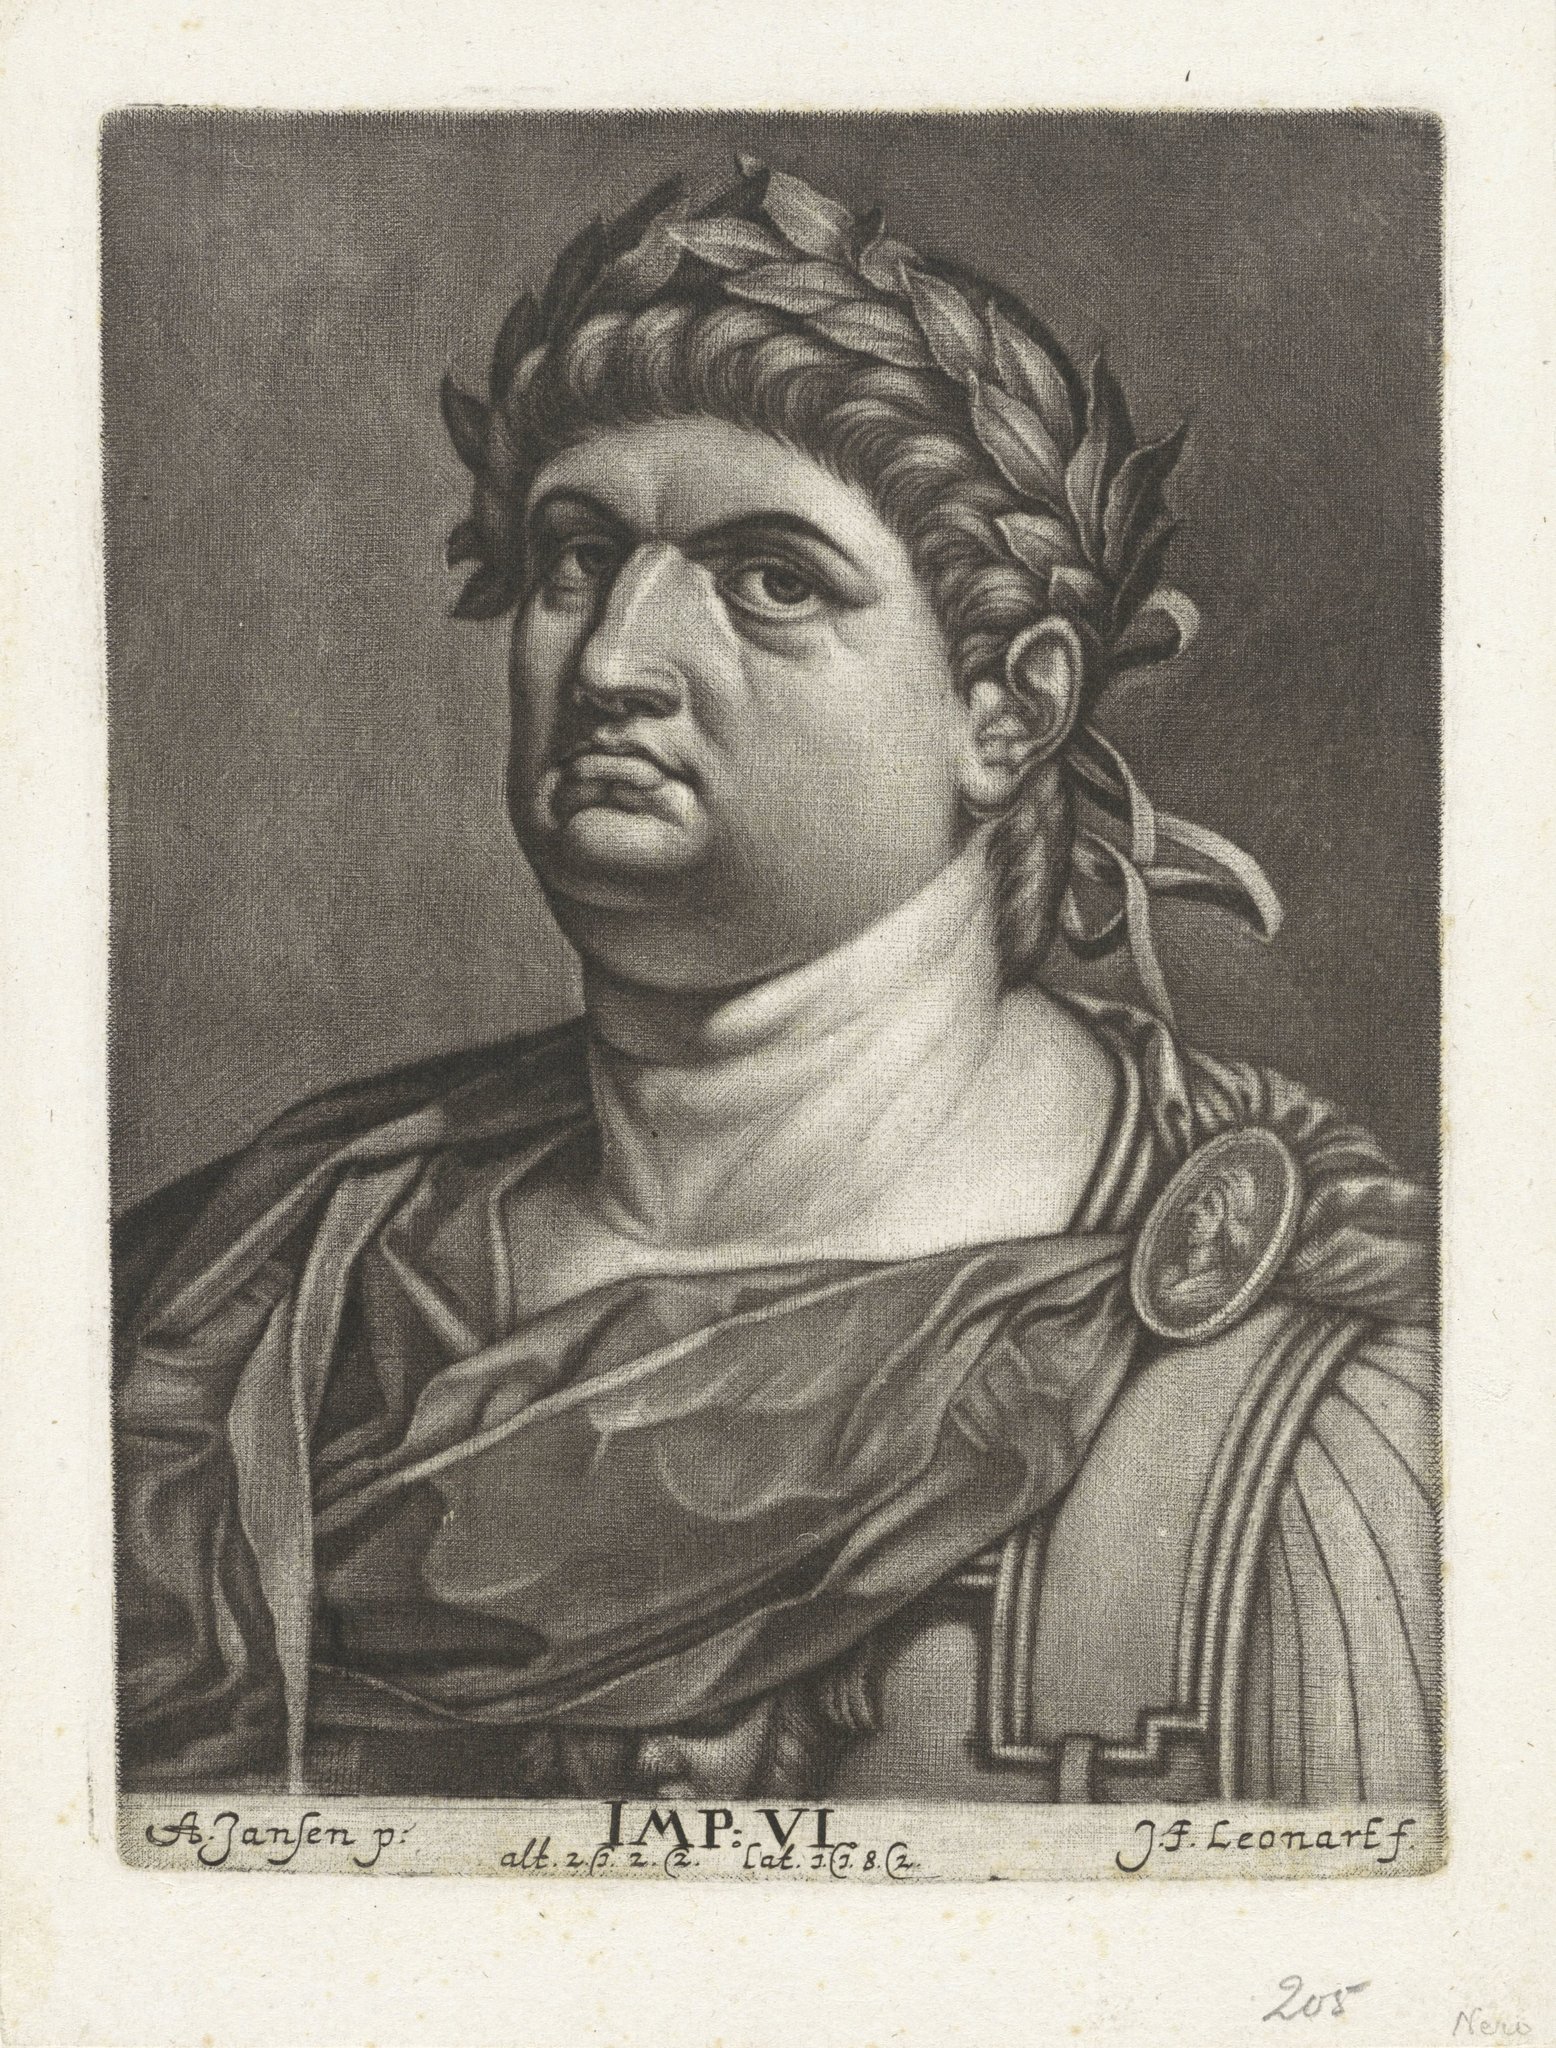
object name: print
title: Portret van keizer Nero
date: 1643-1680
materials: paper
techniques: engraving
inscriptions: collector's mark: Lugt 2166